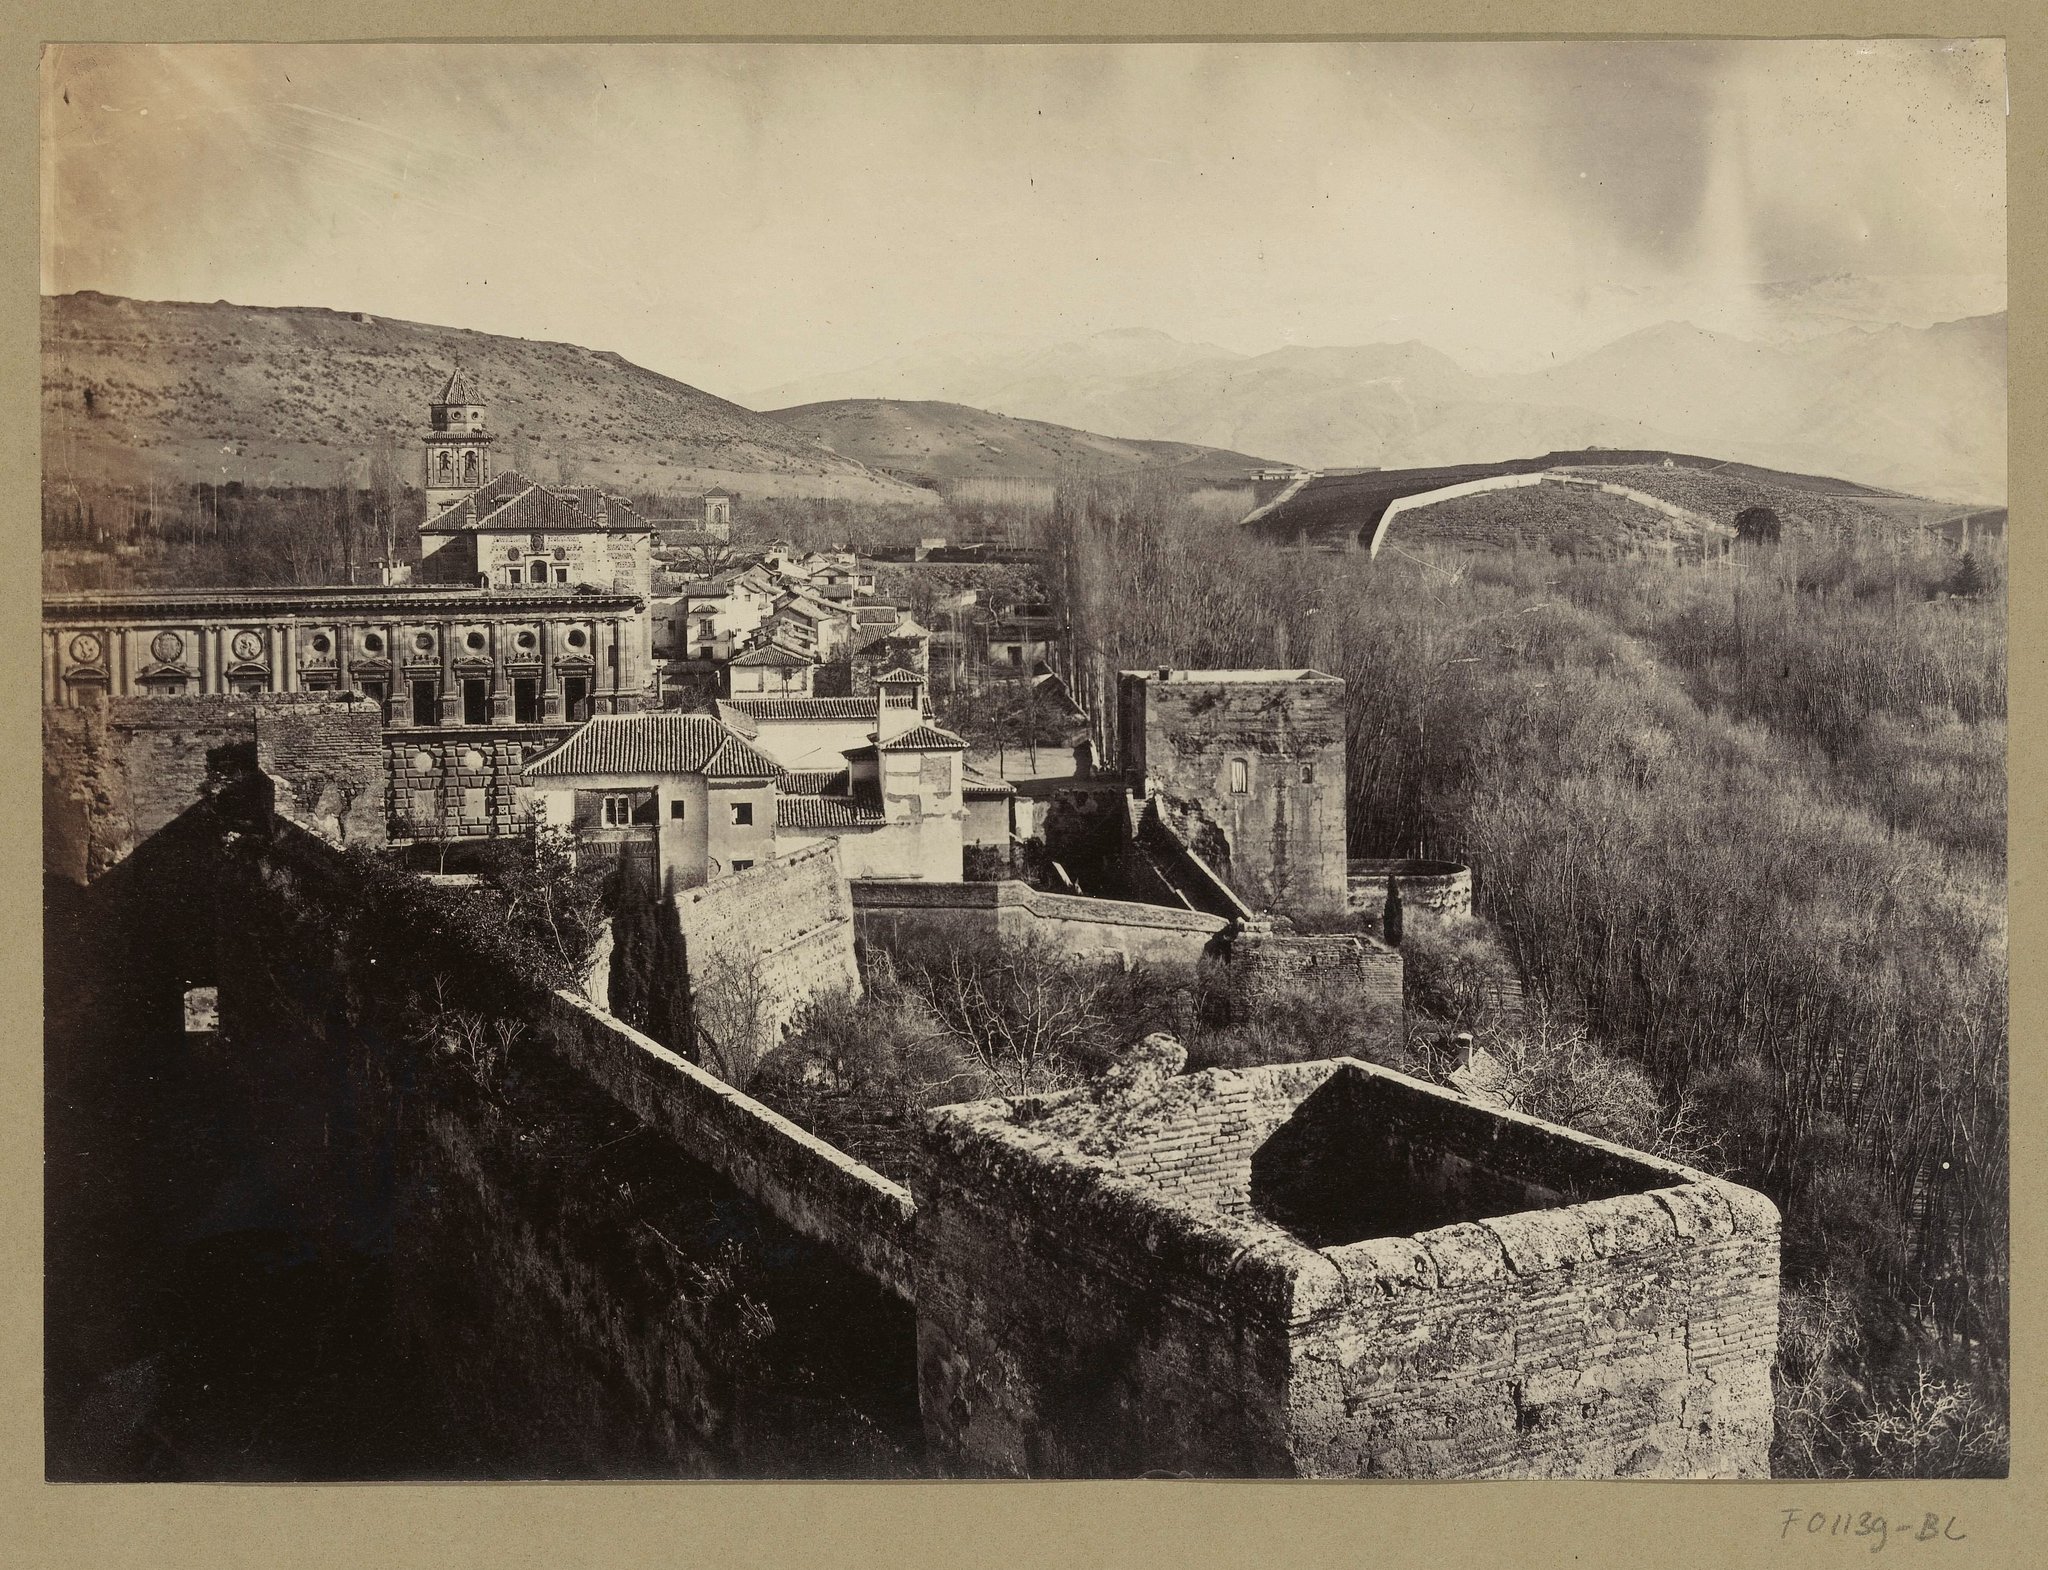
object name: photograph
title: Gezicht op Granada en de Sierra Nevada, links het Alhambra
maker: Anonymous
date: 1851-1890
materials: paper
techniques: albumen print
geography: granada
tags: city-view in general; 'veduta', mountains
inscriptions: inscription: ‘Granada’